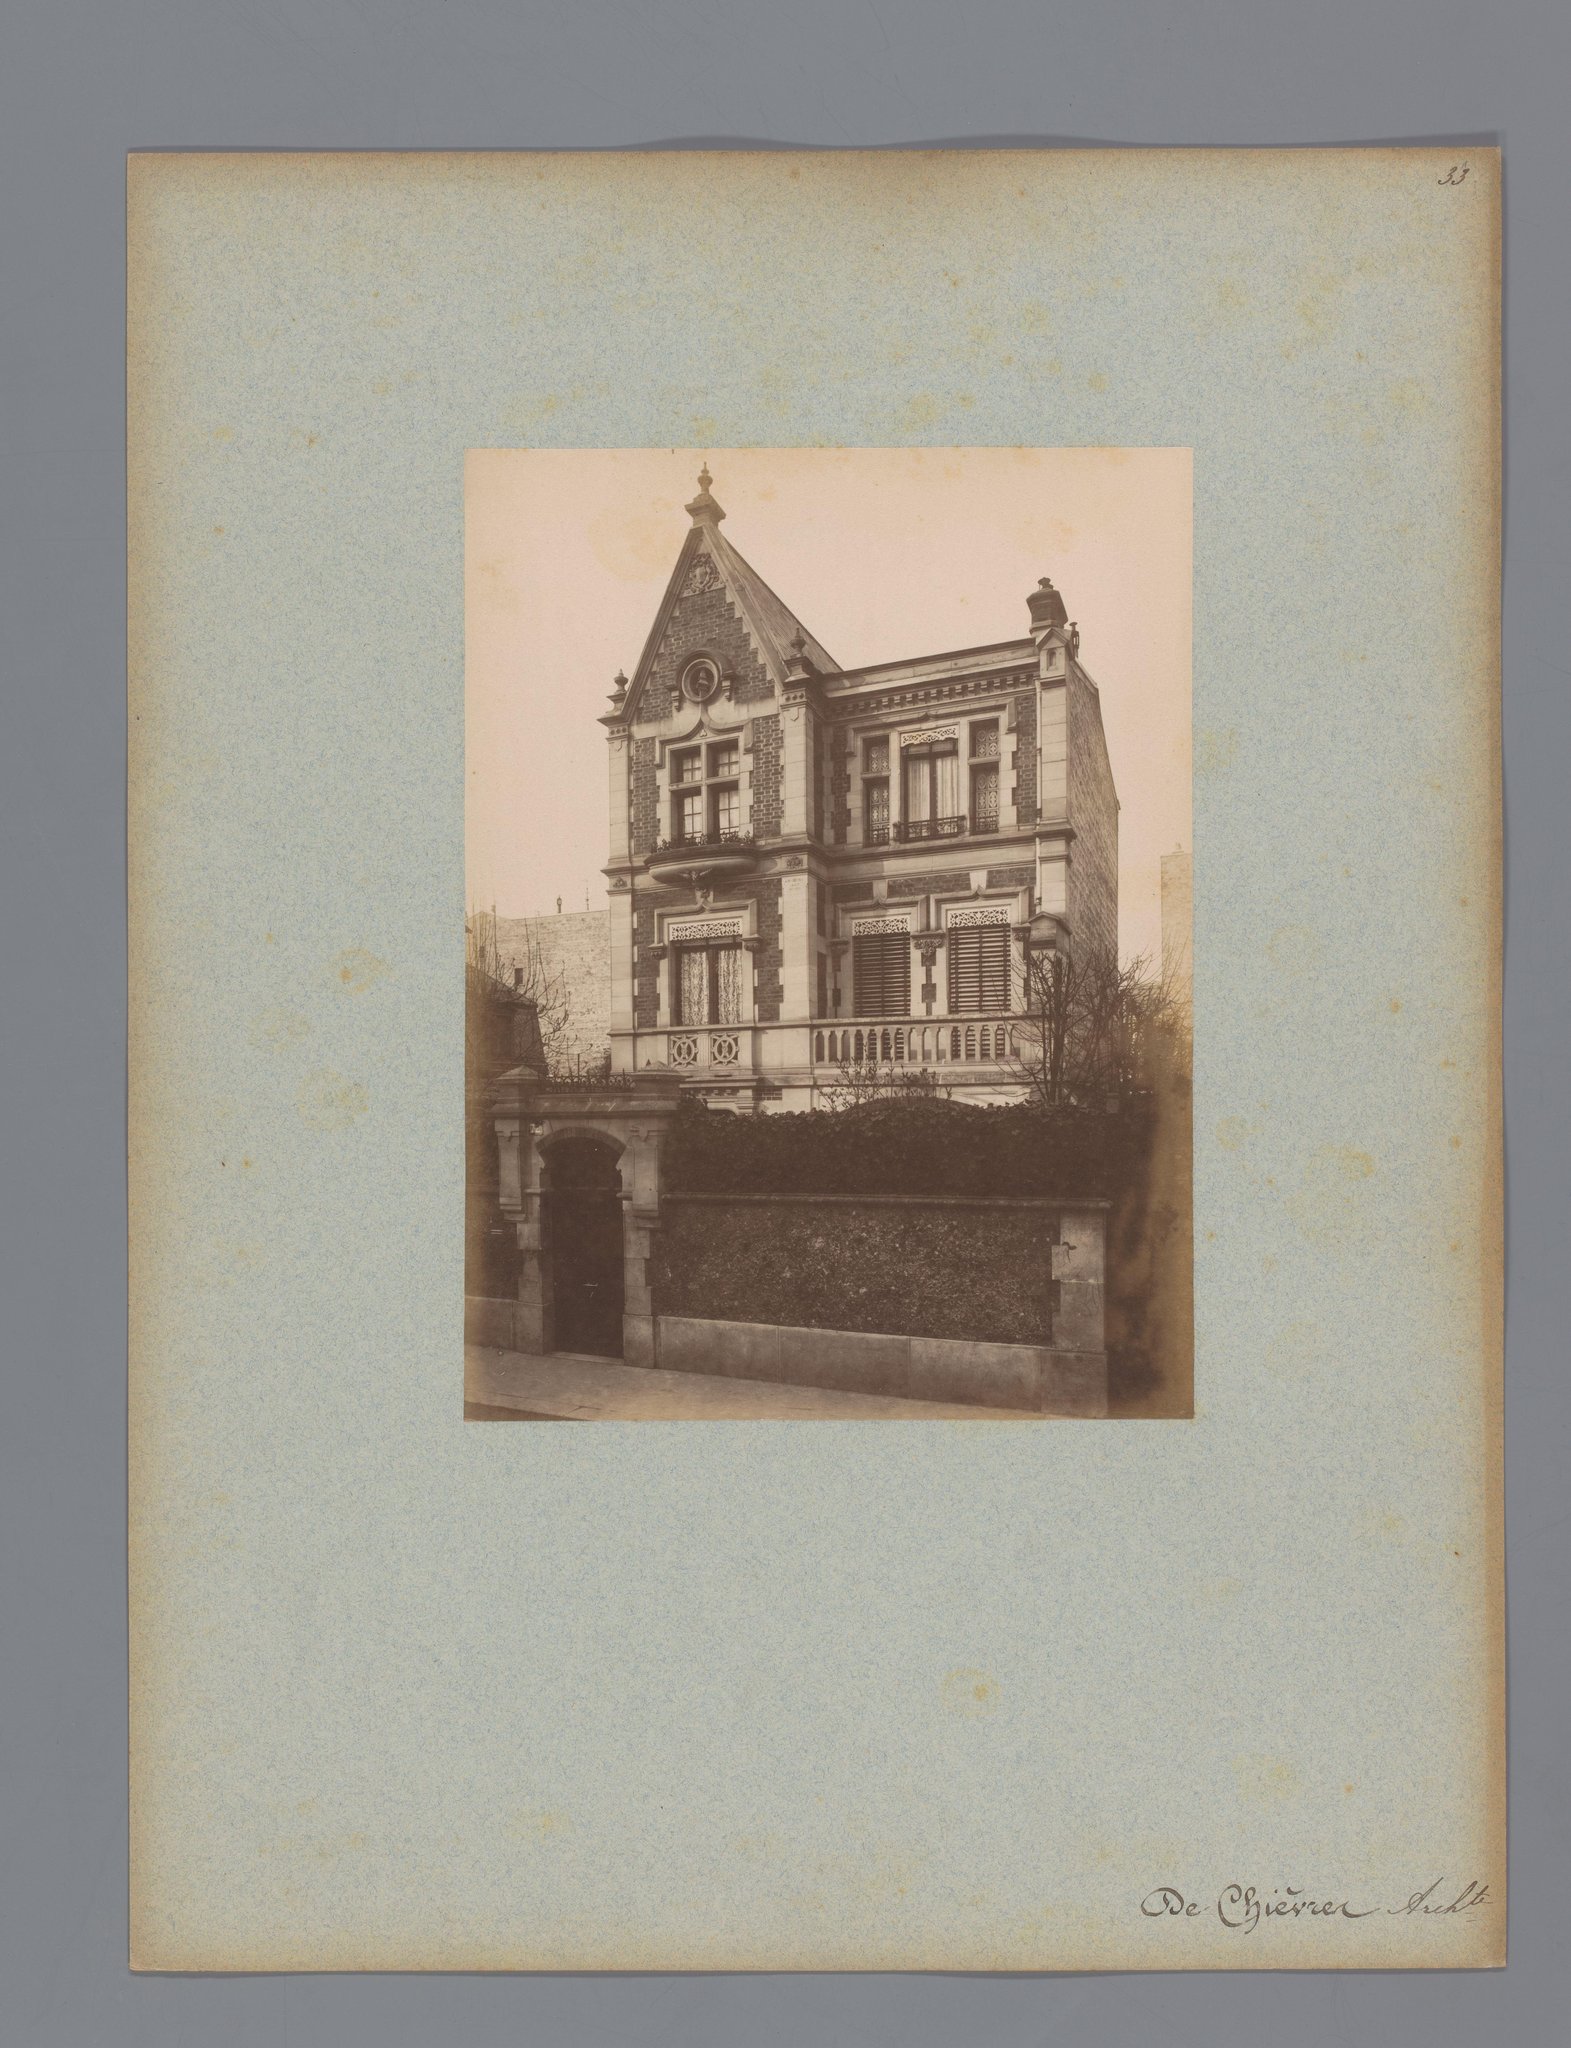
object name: photograph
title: Façade van een villa in Parijs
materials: photographic support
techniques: albumen print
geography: paris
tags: detached house in city, façade (of house or building), paris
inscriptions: name: ‘De Chièvre[.] Archte’, number: ‘33’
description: Deze foto maakt deel uit van een omslag met 35 foto's en een titelblad.